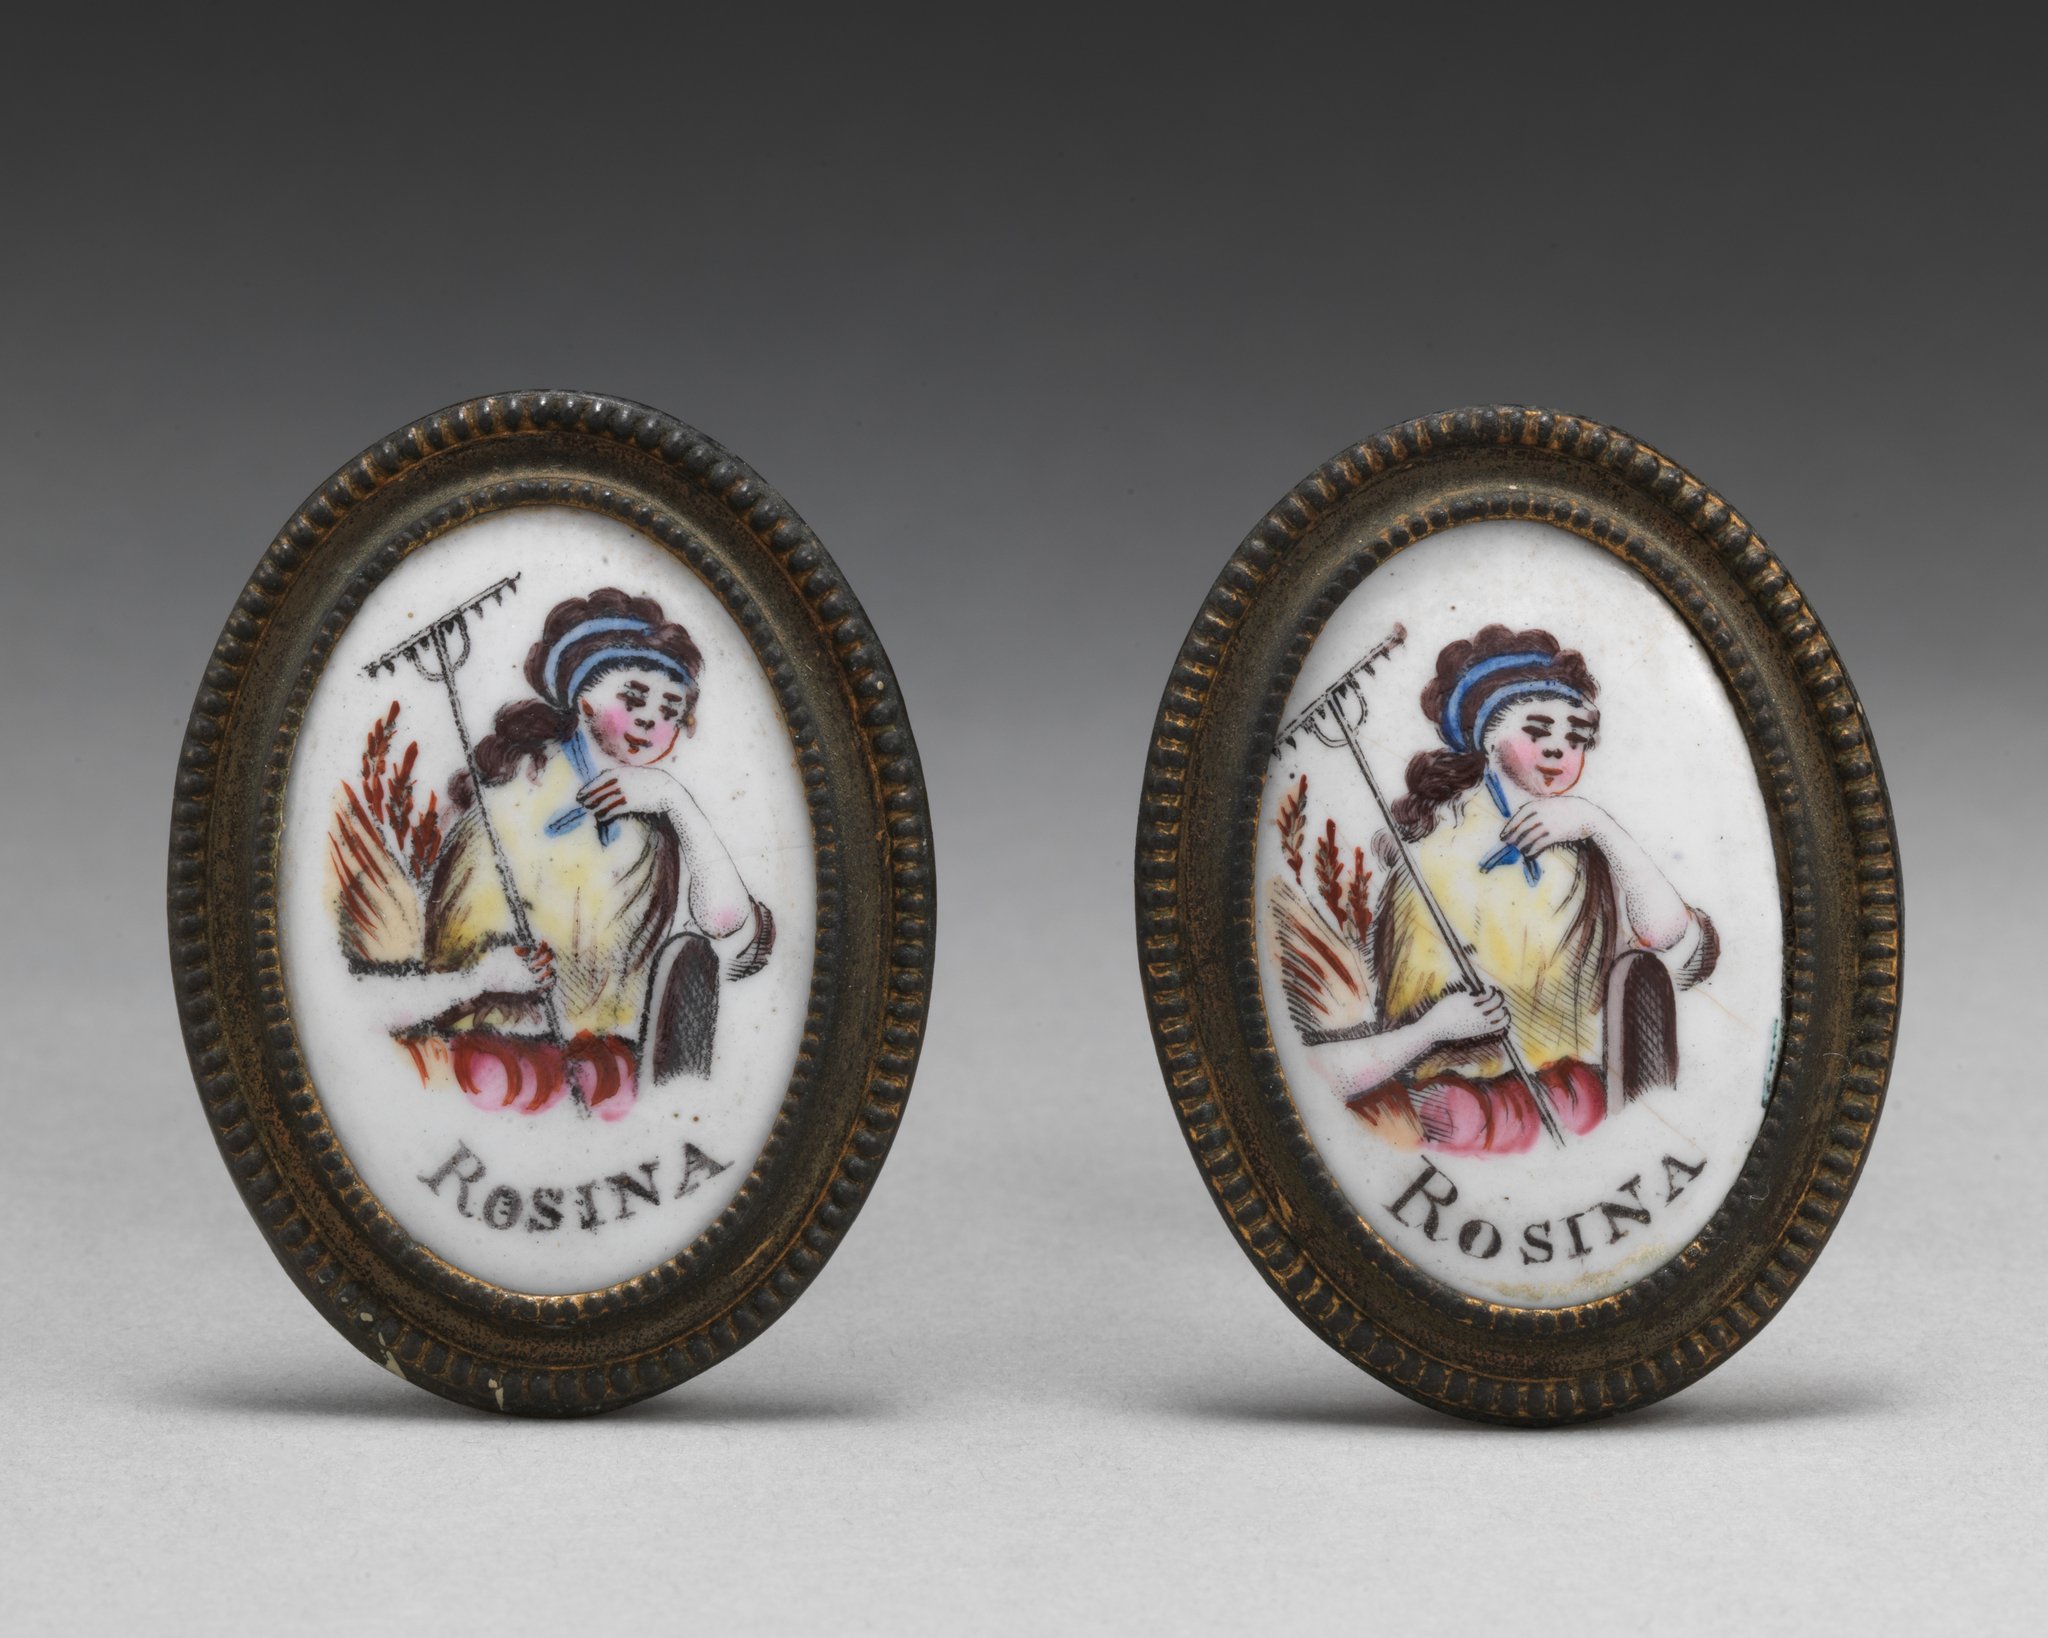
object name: knob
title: Pair of knobs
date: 1782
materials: brass, copper, enamel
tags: women